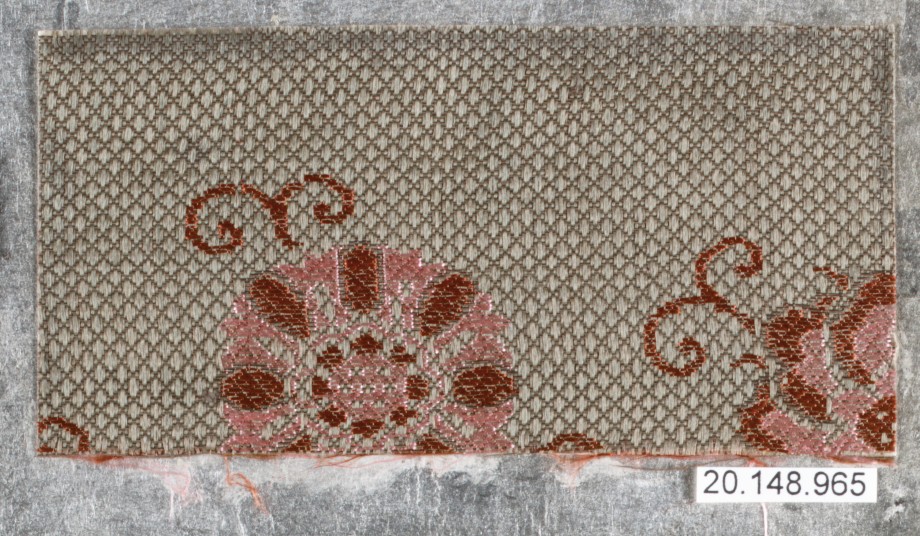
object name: piece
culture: japanese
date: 1801-1900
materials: silk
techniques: compound weave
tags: flowers